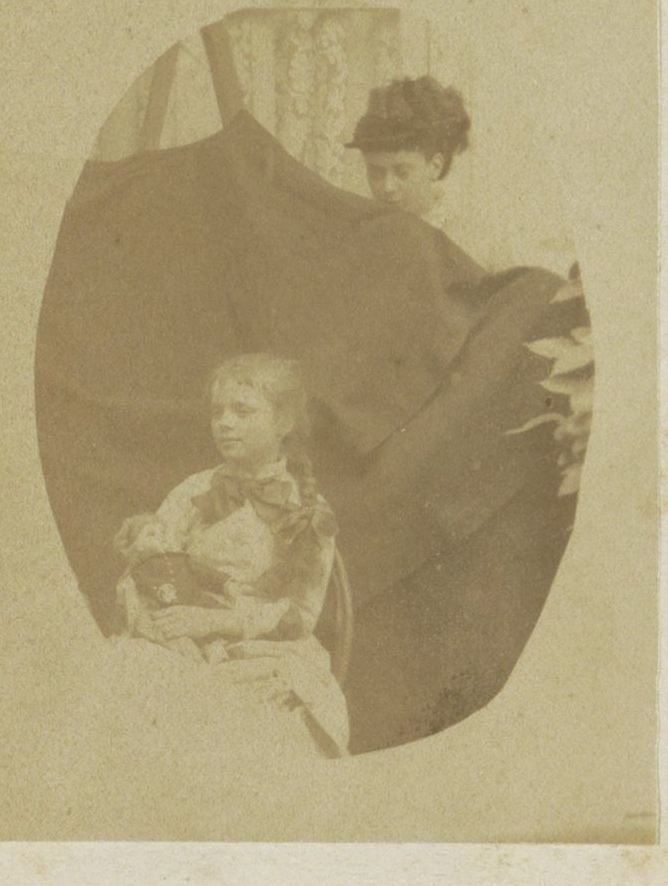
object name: photograph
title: Portret van een kind met een pop, achter haar een vrouw die een achtergronddoek vasthoudt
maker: Anonymous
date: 1883-1886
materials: photographic support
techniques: albumen print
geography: france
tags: studio requisites ~ photographer, (playing with) dolls, mother and baby or young child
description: Onderdeel van Album van een Franse amateurfotograaf met opnames van familie, militairen, industrie, landschappen en bezienswaardigheden in Frankrijk.